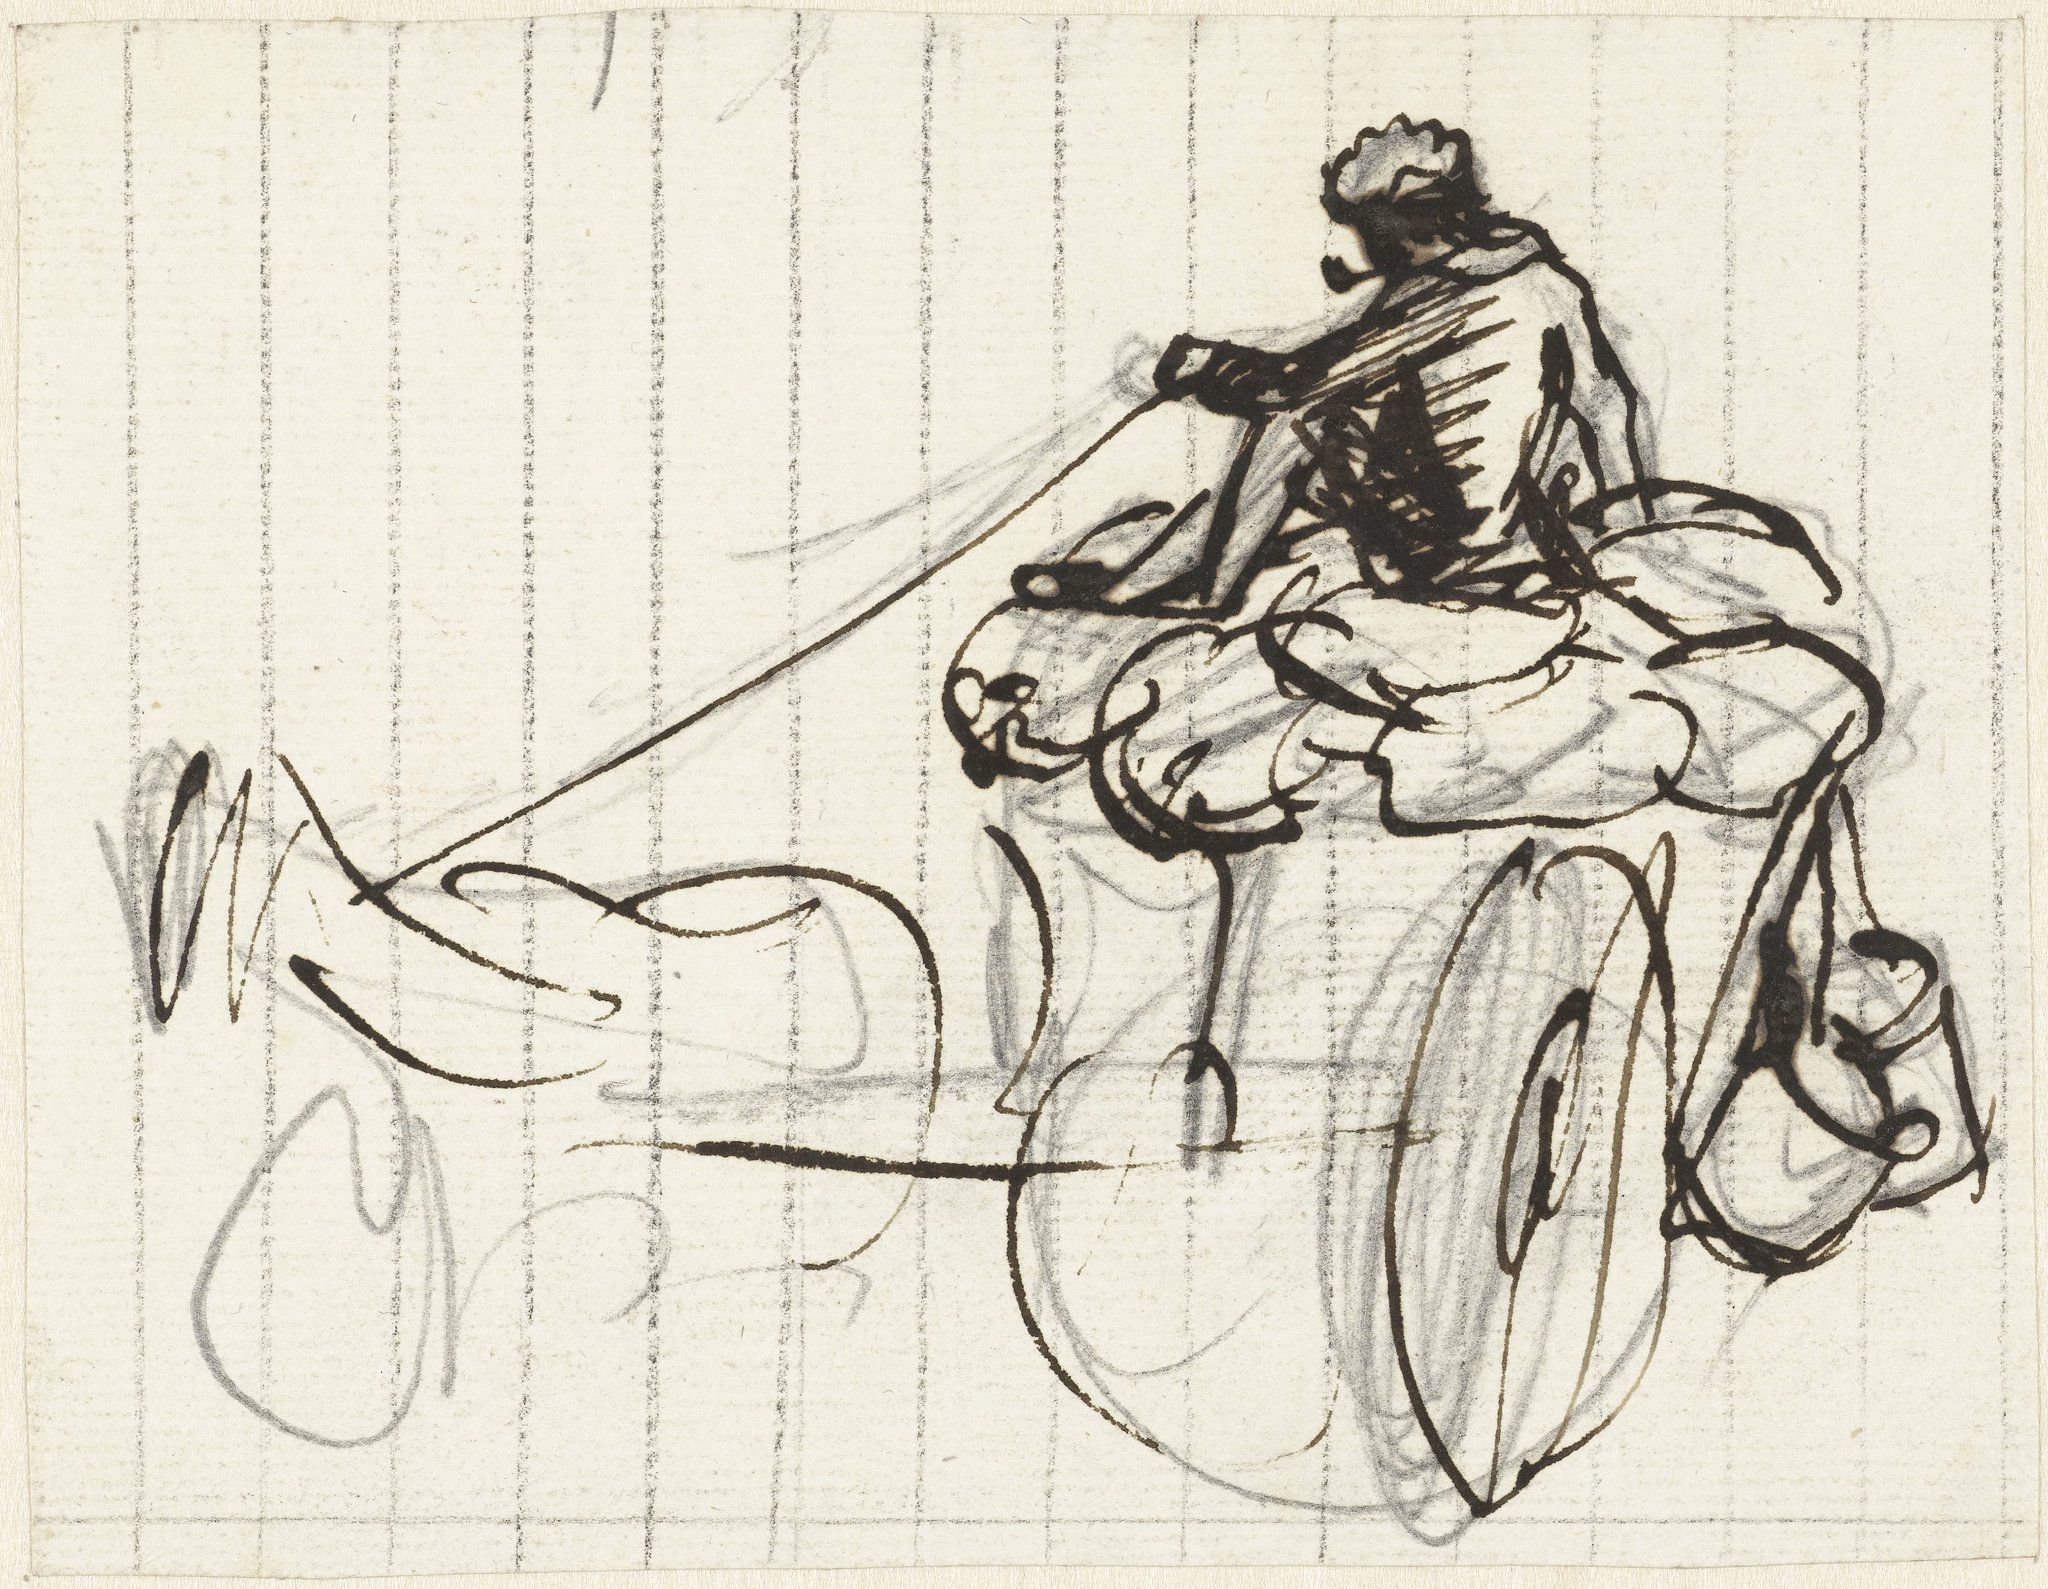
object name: drawing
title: Hooiwagen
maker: simon andreas krausz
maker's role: draughtsman, print maker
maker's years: 1760-1825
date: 1770-1825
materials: chalk, ink, paper, pencil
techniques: pen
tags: hay-wagon